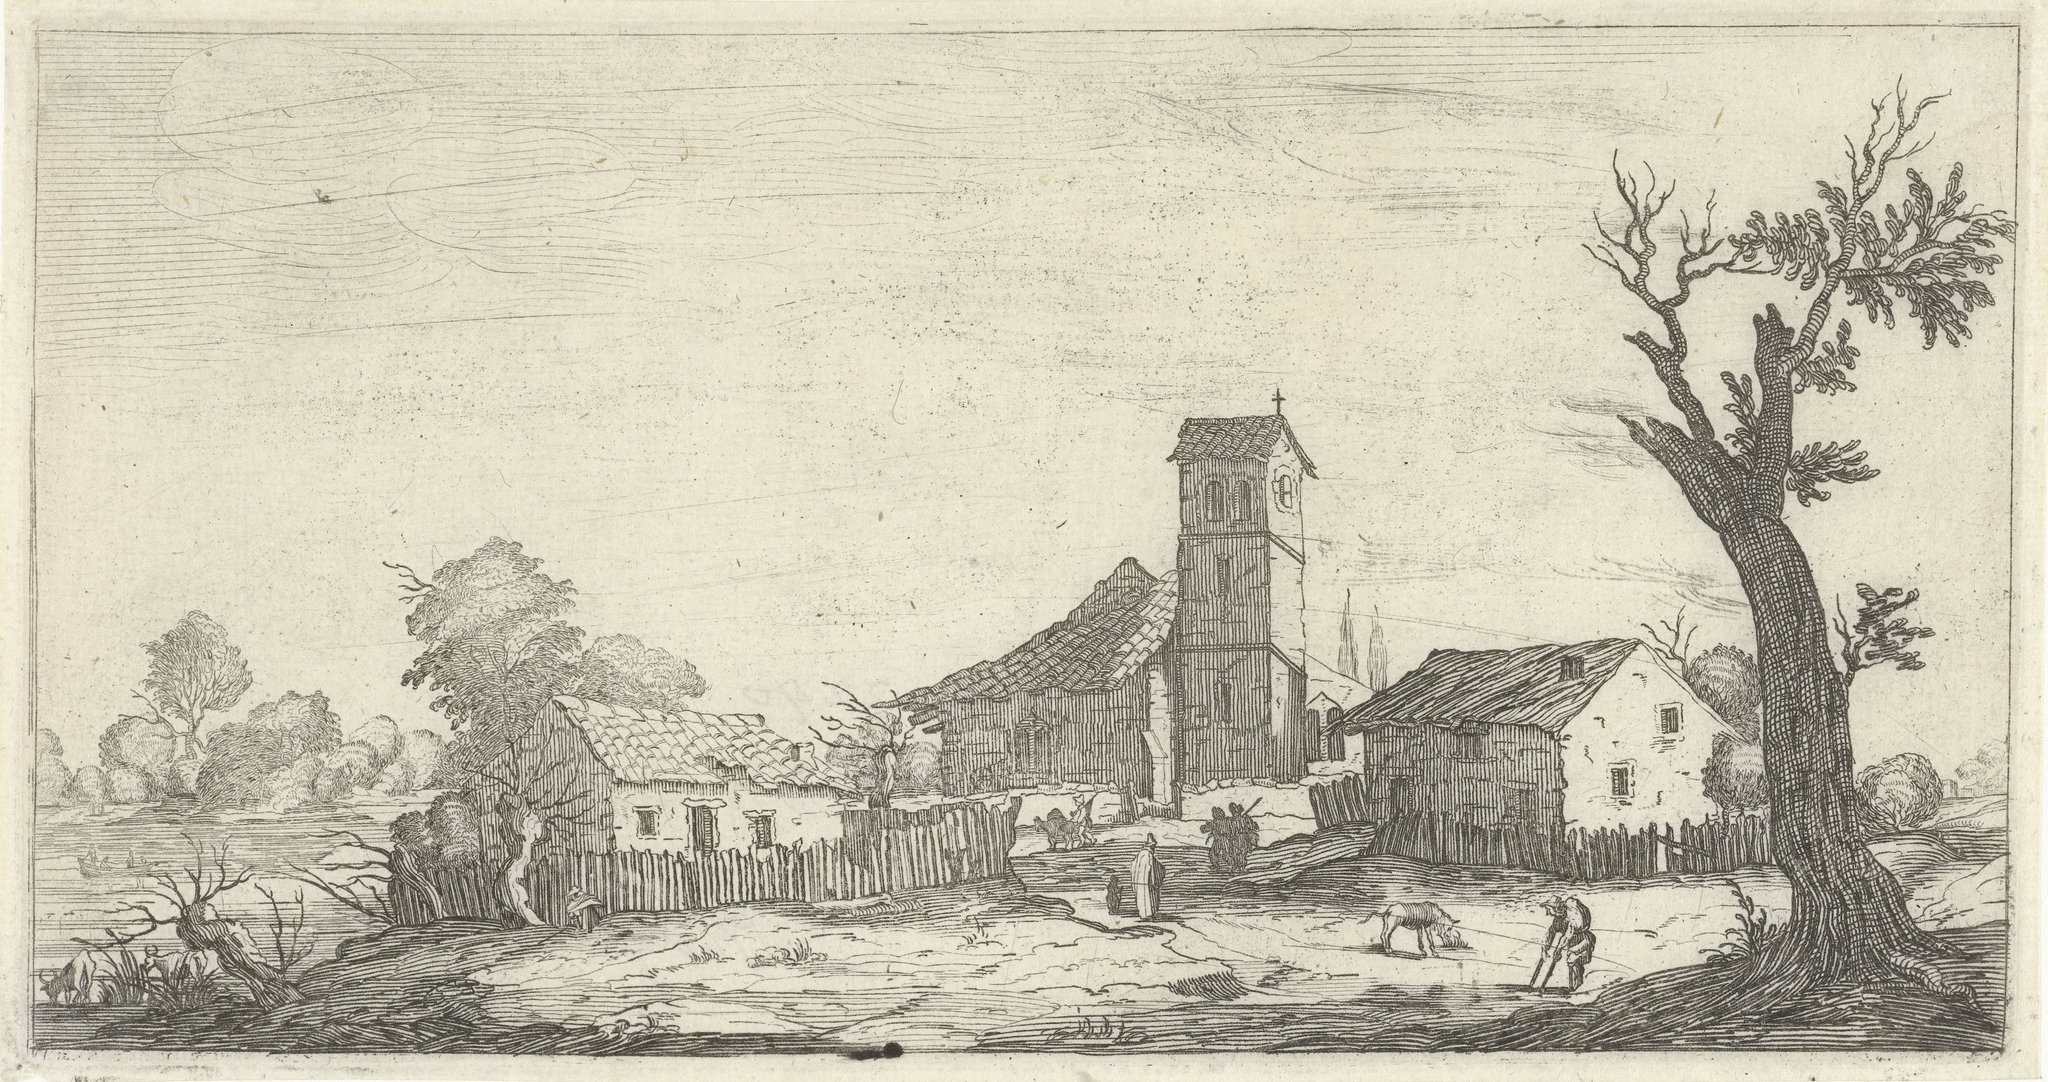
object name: print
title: Italiaans landschap met een dorpje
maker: lievin cruyl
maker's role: draughtsman, print maker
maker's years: 1634-1720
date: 1650-1720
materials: paper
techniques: etching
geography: rome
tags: village, landscape with ruins (+ city(-scape) with figures, staffage), italy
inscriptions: collector's mark: Lugt 2228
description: Landschap met een italiaans dorpje. Centraal in het dorpje een kerk.